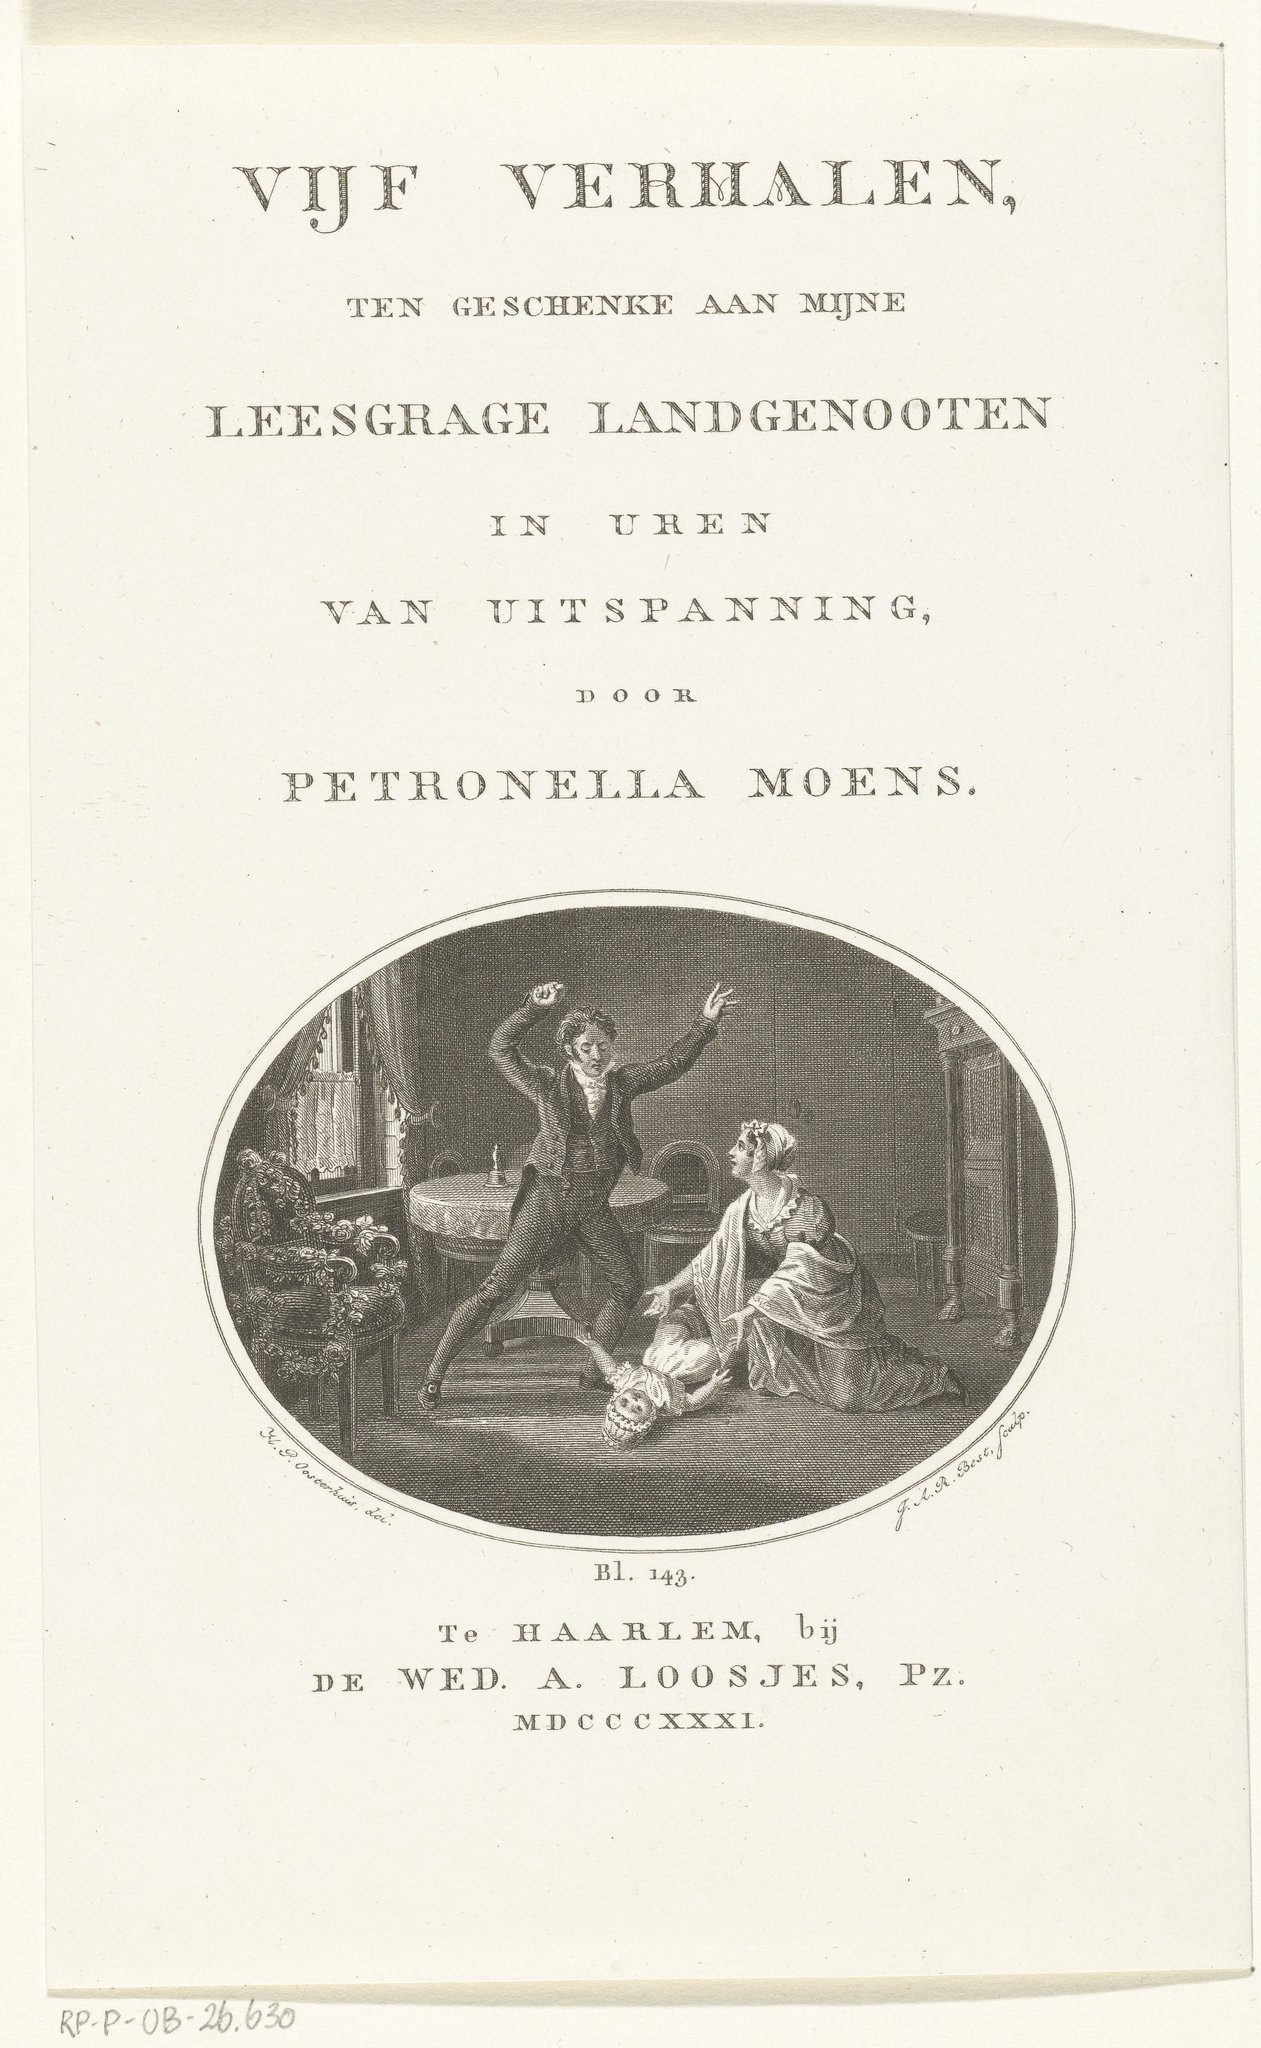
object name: print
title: Titelpagina voor: Petronella Moens, Vijf Verhalen, ten geschenke aan mijne leesgrage landgenooten in uren van uitspanning, Haarlem 1831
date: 1807-1831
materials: paper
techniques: etching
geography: haarlem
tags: family life, falling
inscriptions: collector's mark: Lugt 2228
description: Titelpagina voor: Petronella Moens, Vijf Verhalen, ten geschenke aan mijne leesgrage landgenooten in uren van uitspanning, Wed. A. Loosjes Pz. (uitgever), Haarlem 1831, illustratie bij tekst op p. 143.